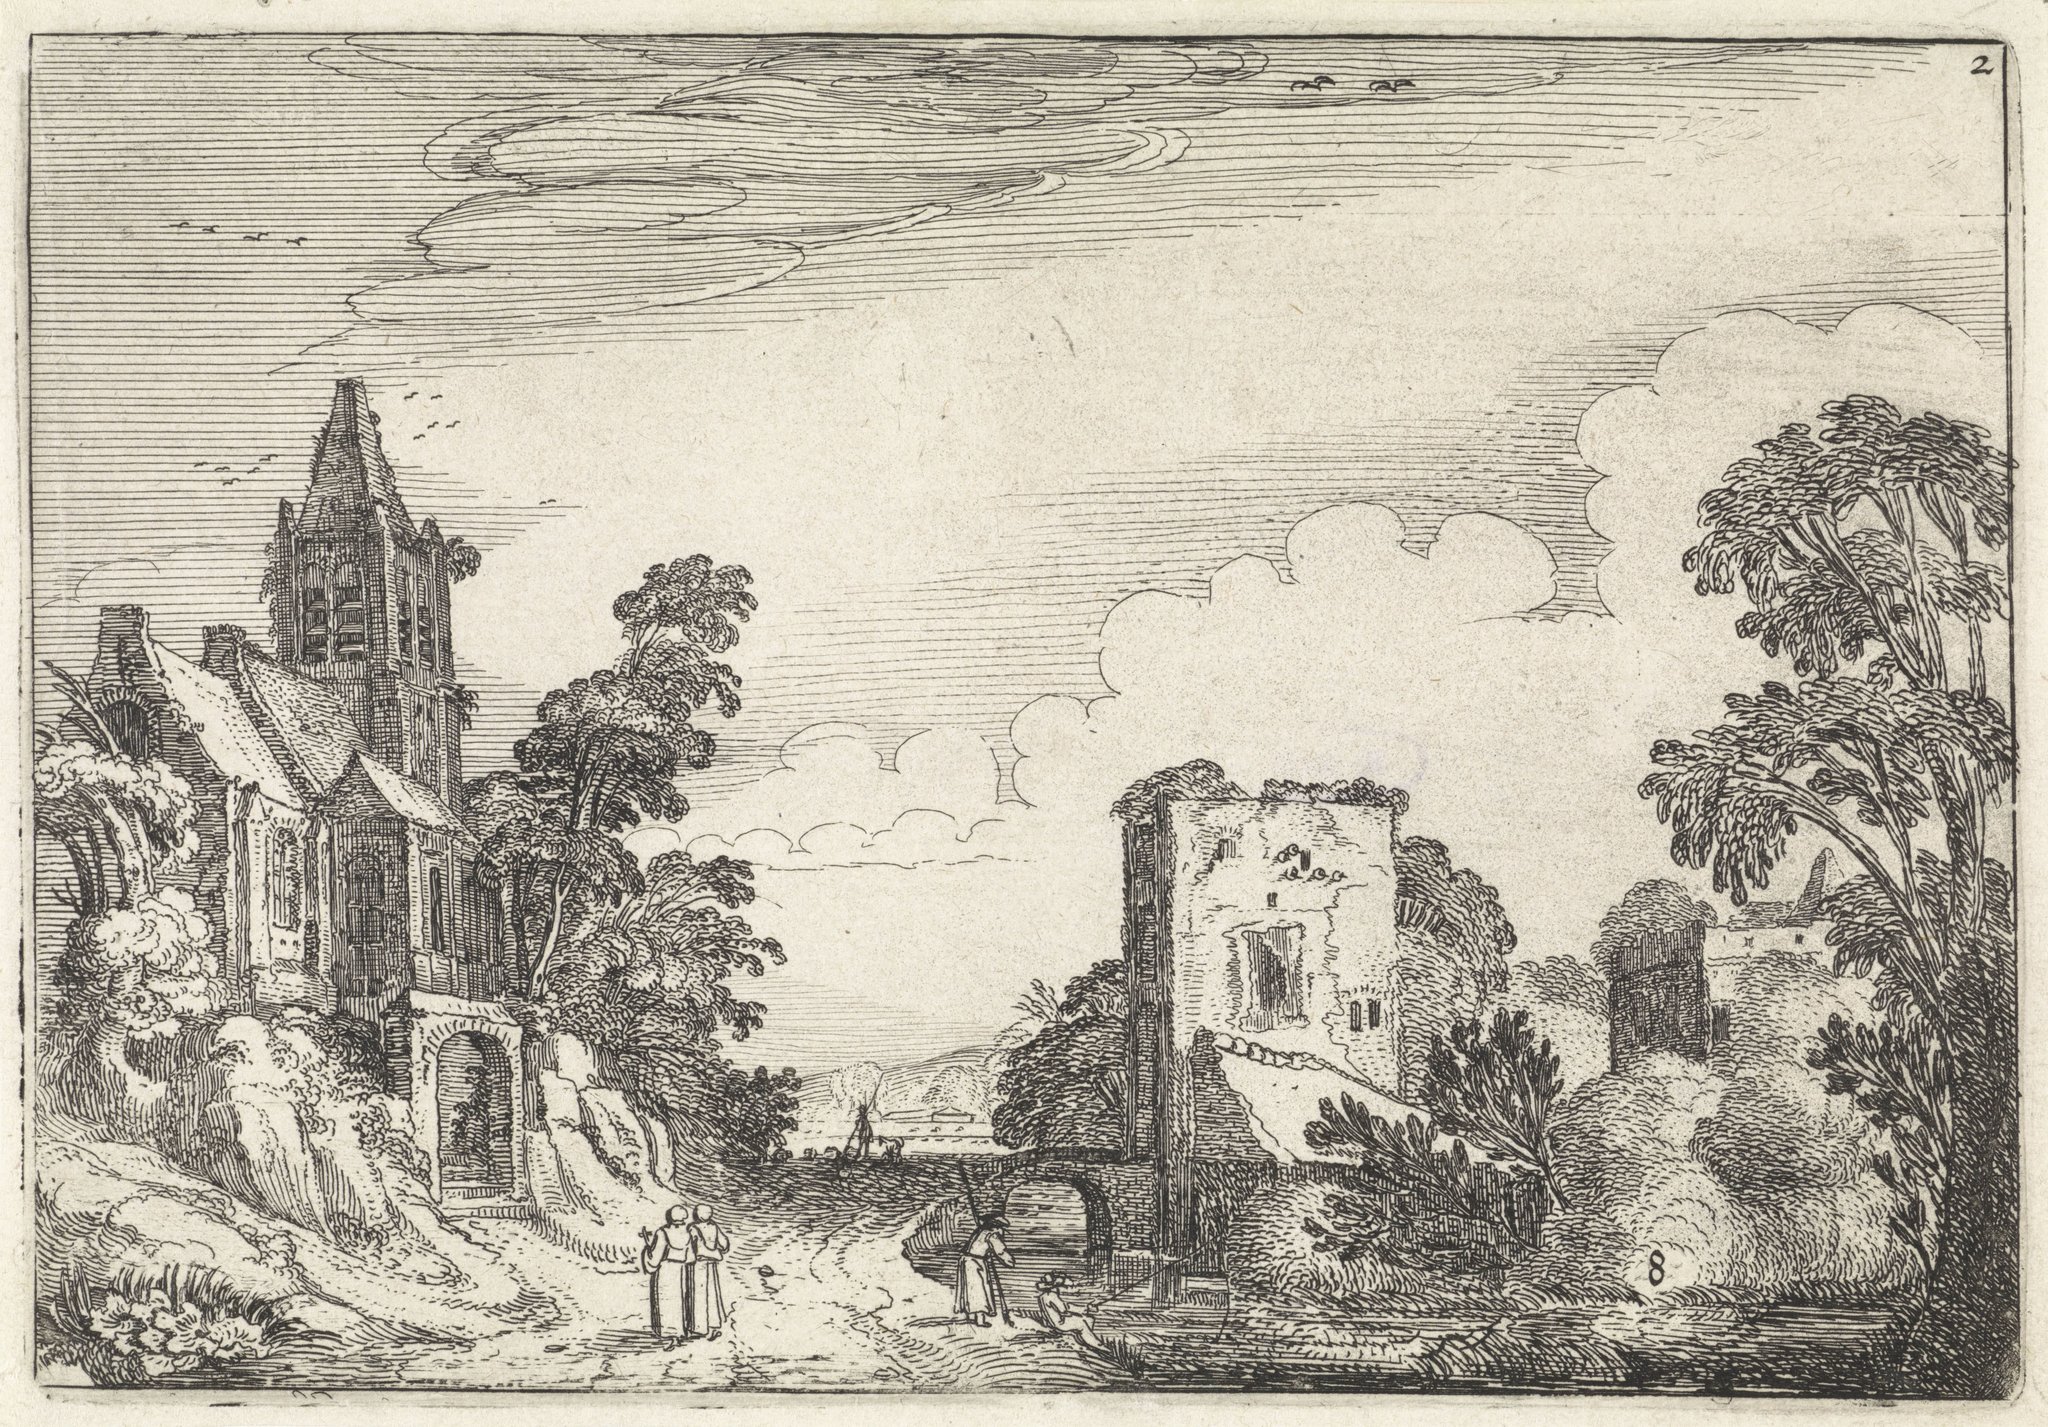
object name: print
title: Amenissimae aliquot requculae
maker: jan van de velde (ii)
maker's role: draughtsman, painter, print maker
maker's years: 1593-1641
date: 1616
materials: paper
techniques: etching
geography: northern netherlands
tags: landscape with bridge, viaduct or aqueduct, landscape with tower or castle, angling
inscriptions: collector's mark: Lugt 964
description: Een hengelaar en een tweede figuur aan de oever van een stroom bij een toren in een landschap. Voor de toren een stenen brug. Links een kerk en op het pad ervoor twee geestelijken. Achtste prent van deel twee van een serie van in totaal zestig prenten met landschappen, verdeeld over vijf delen van elk twaalf prenten.